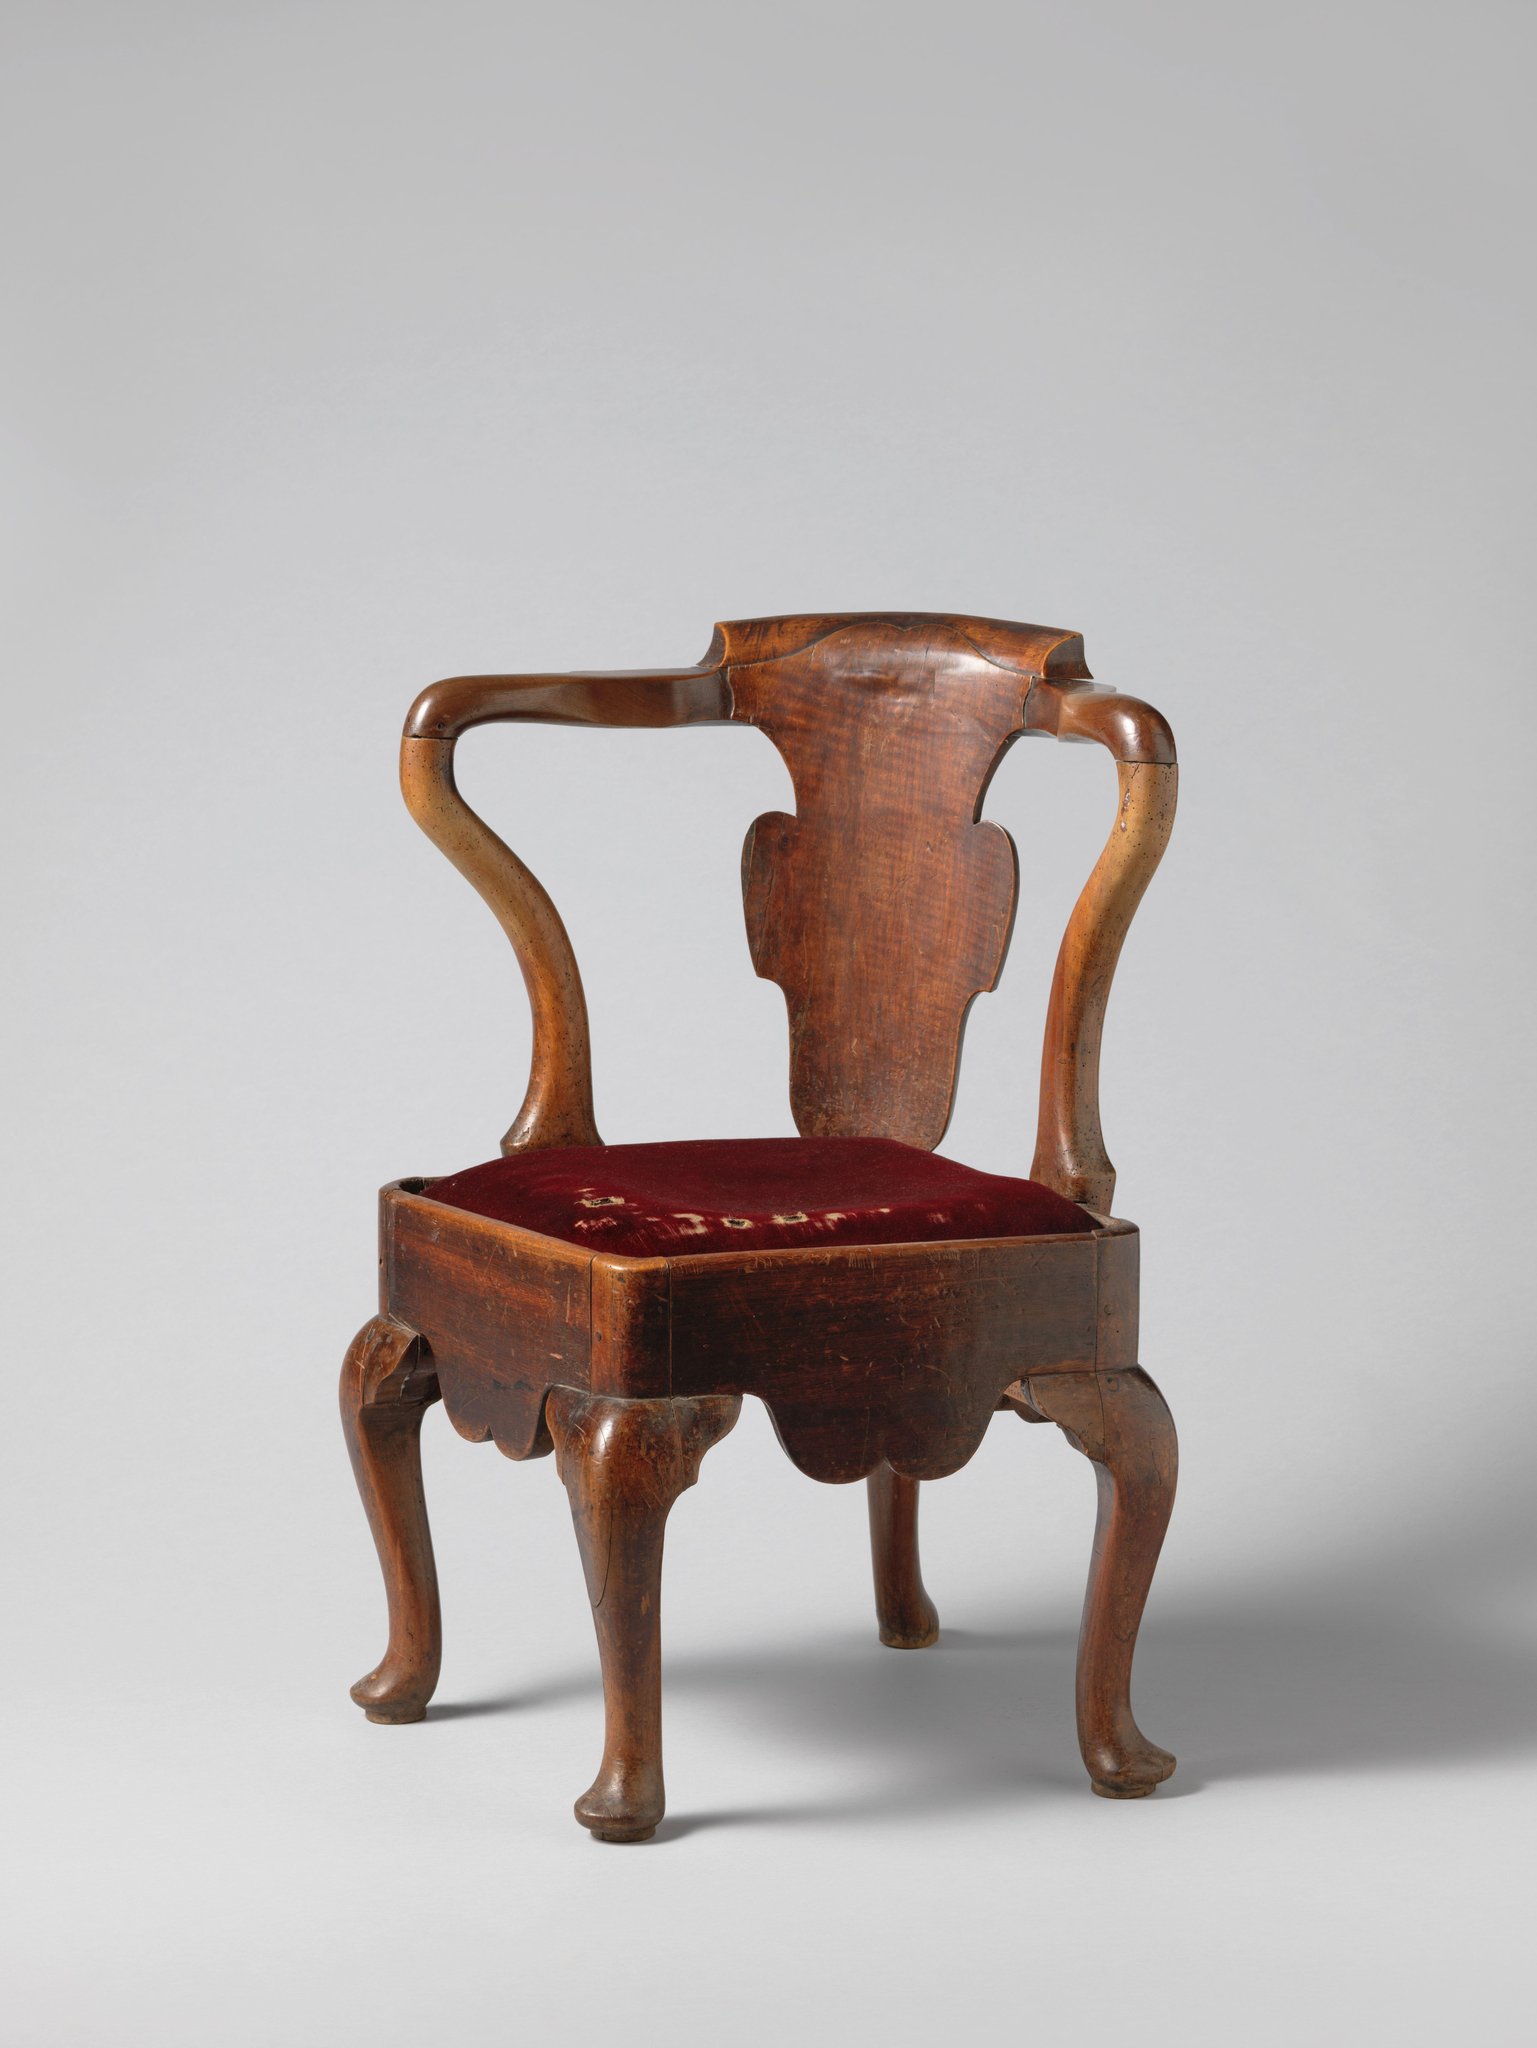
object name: chair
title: Stoel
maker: Anonymous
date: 1750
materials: velvet, wood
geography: great britain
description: Stoel van notenhout met losse zitting van versleten rood fluweel. Het meubel rust op vier overhoeks geplaatste gestrekt S-vormige poten. De brede regels zijn tussen de poten diep uitgeschulpt. De ver naar achteren geplaatste armleggerstutten zijn gestrekt S-vormig; zij gaan over in de afgeplatte armleggers, die eveneens zonder onderbreking overgaan in het licht geholde symmetrisch uitgezaagde rugpaneel. De rug beslaat twee zijden, waardoor een hoek van het zitraam in het midden is geplaatst.